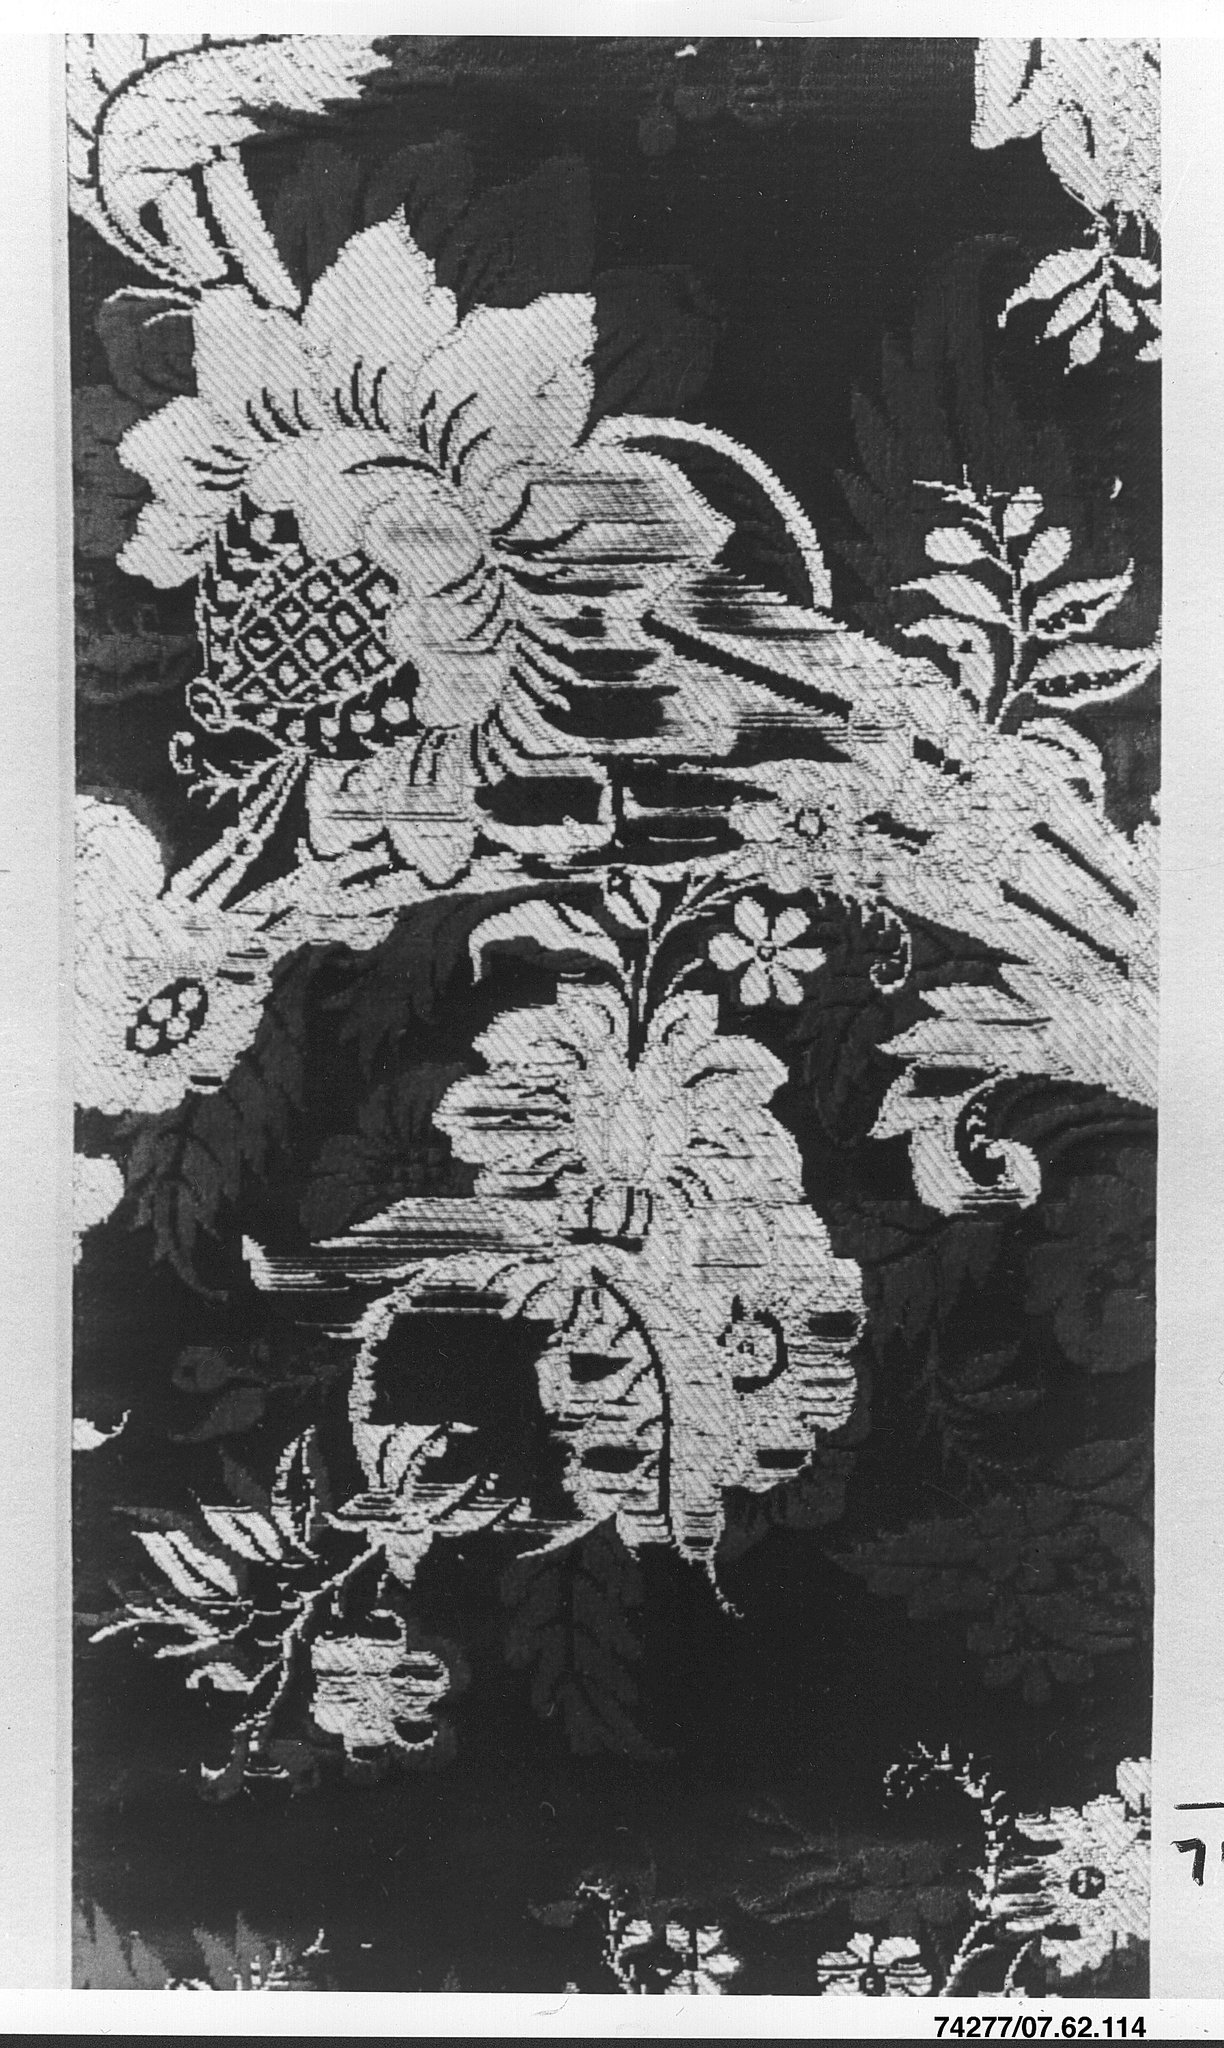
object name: piece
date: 1725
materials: silk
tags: flowers,leaves